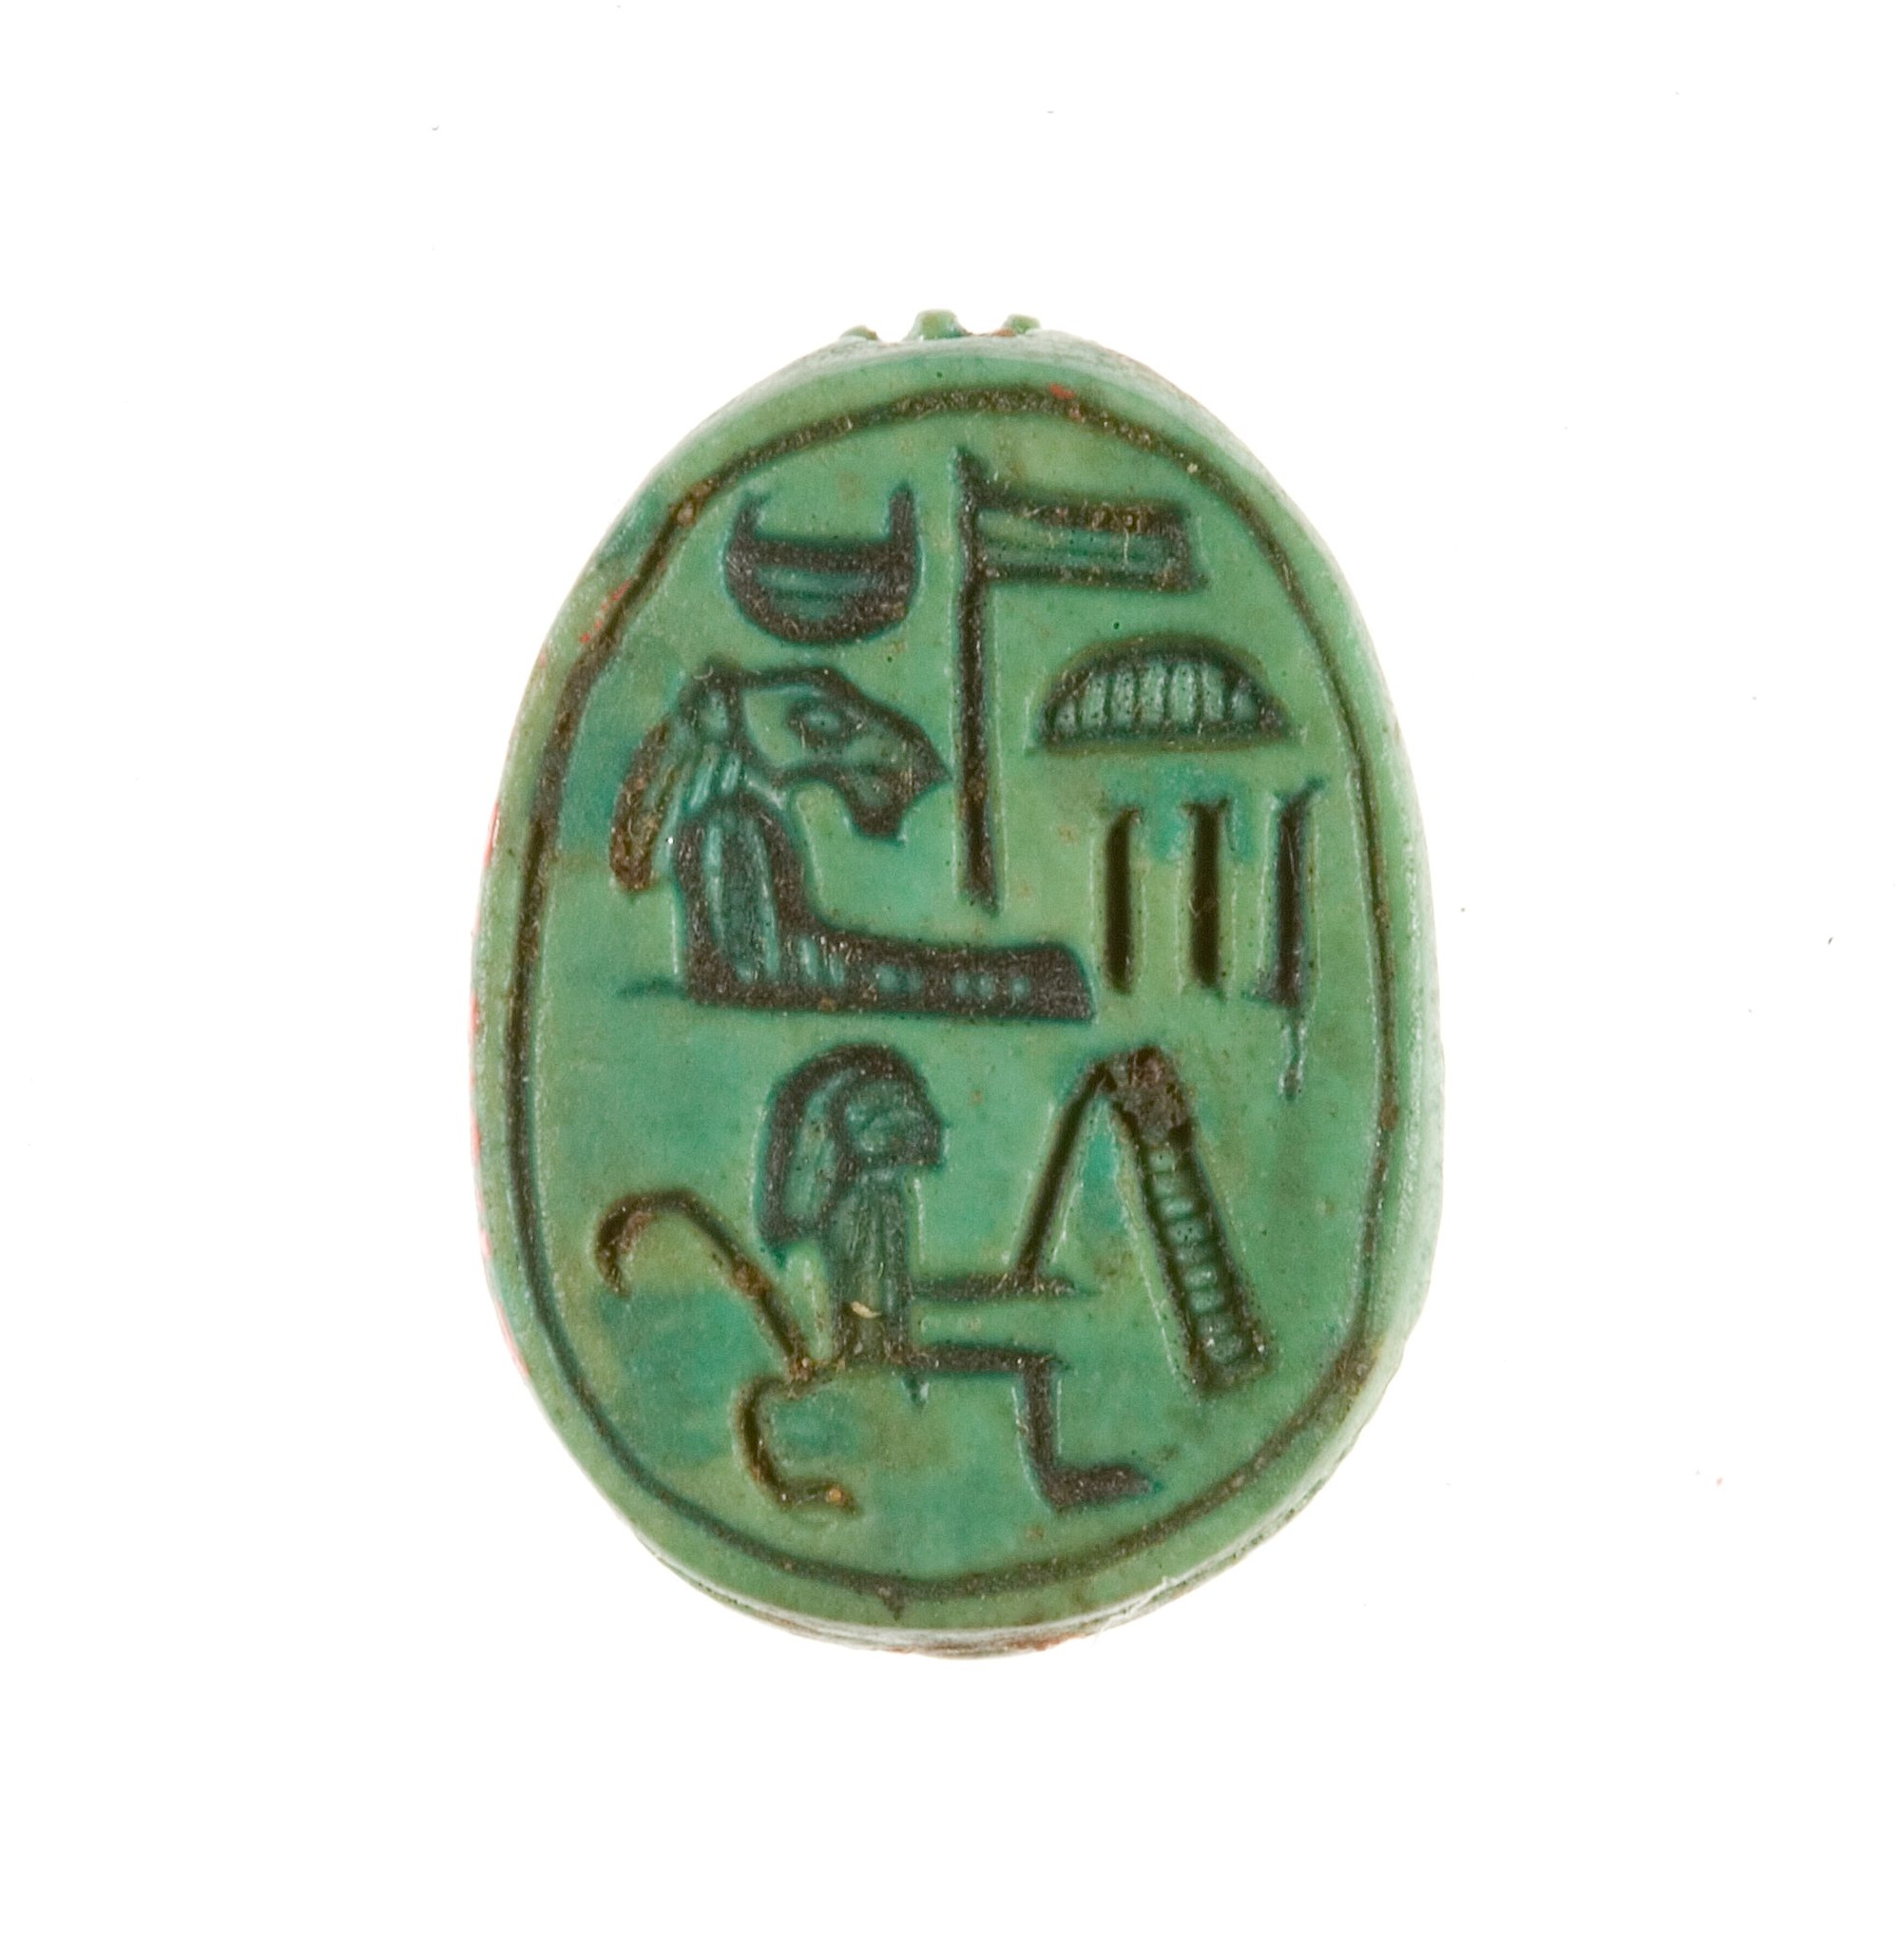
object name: scarab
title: Scarab Inscribed for the God's Wife Hatshepsut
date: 1479-1458 BCE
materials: stone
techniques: glazing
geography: egypt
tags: hieroglyphs,scarabs